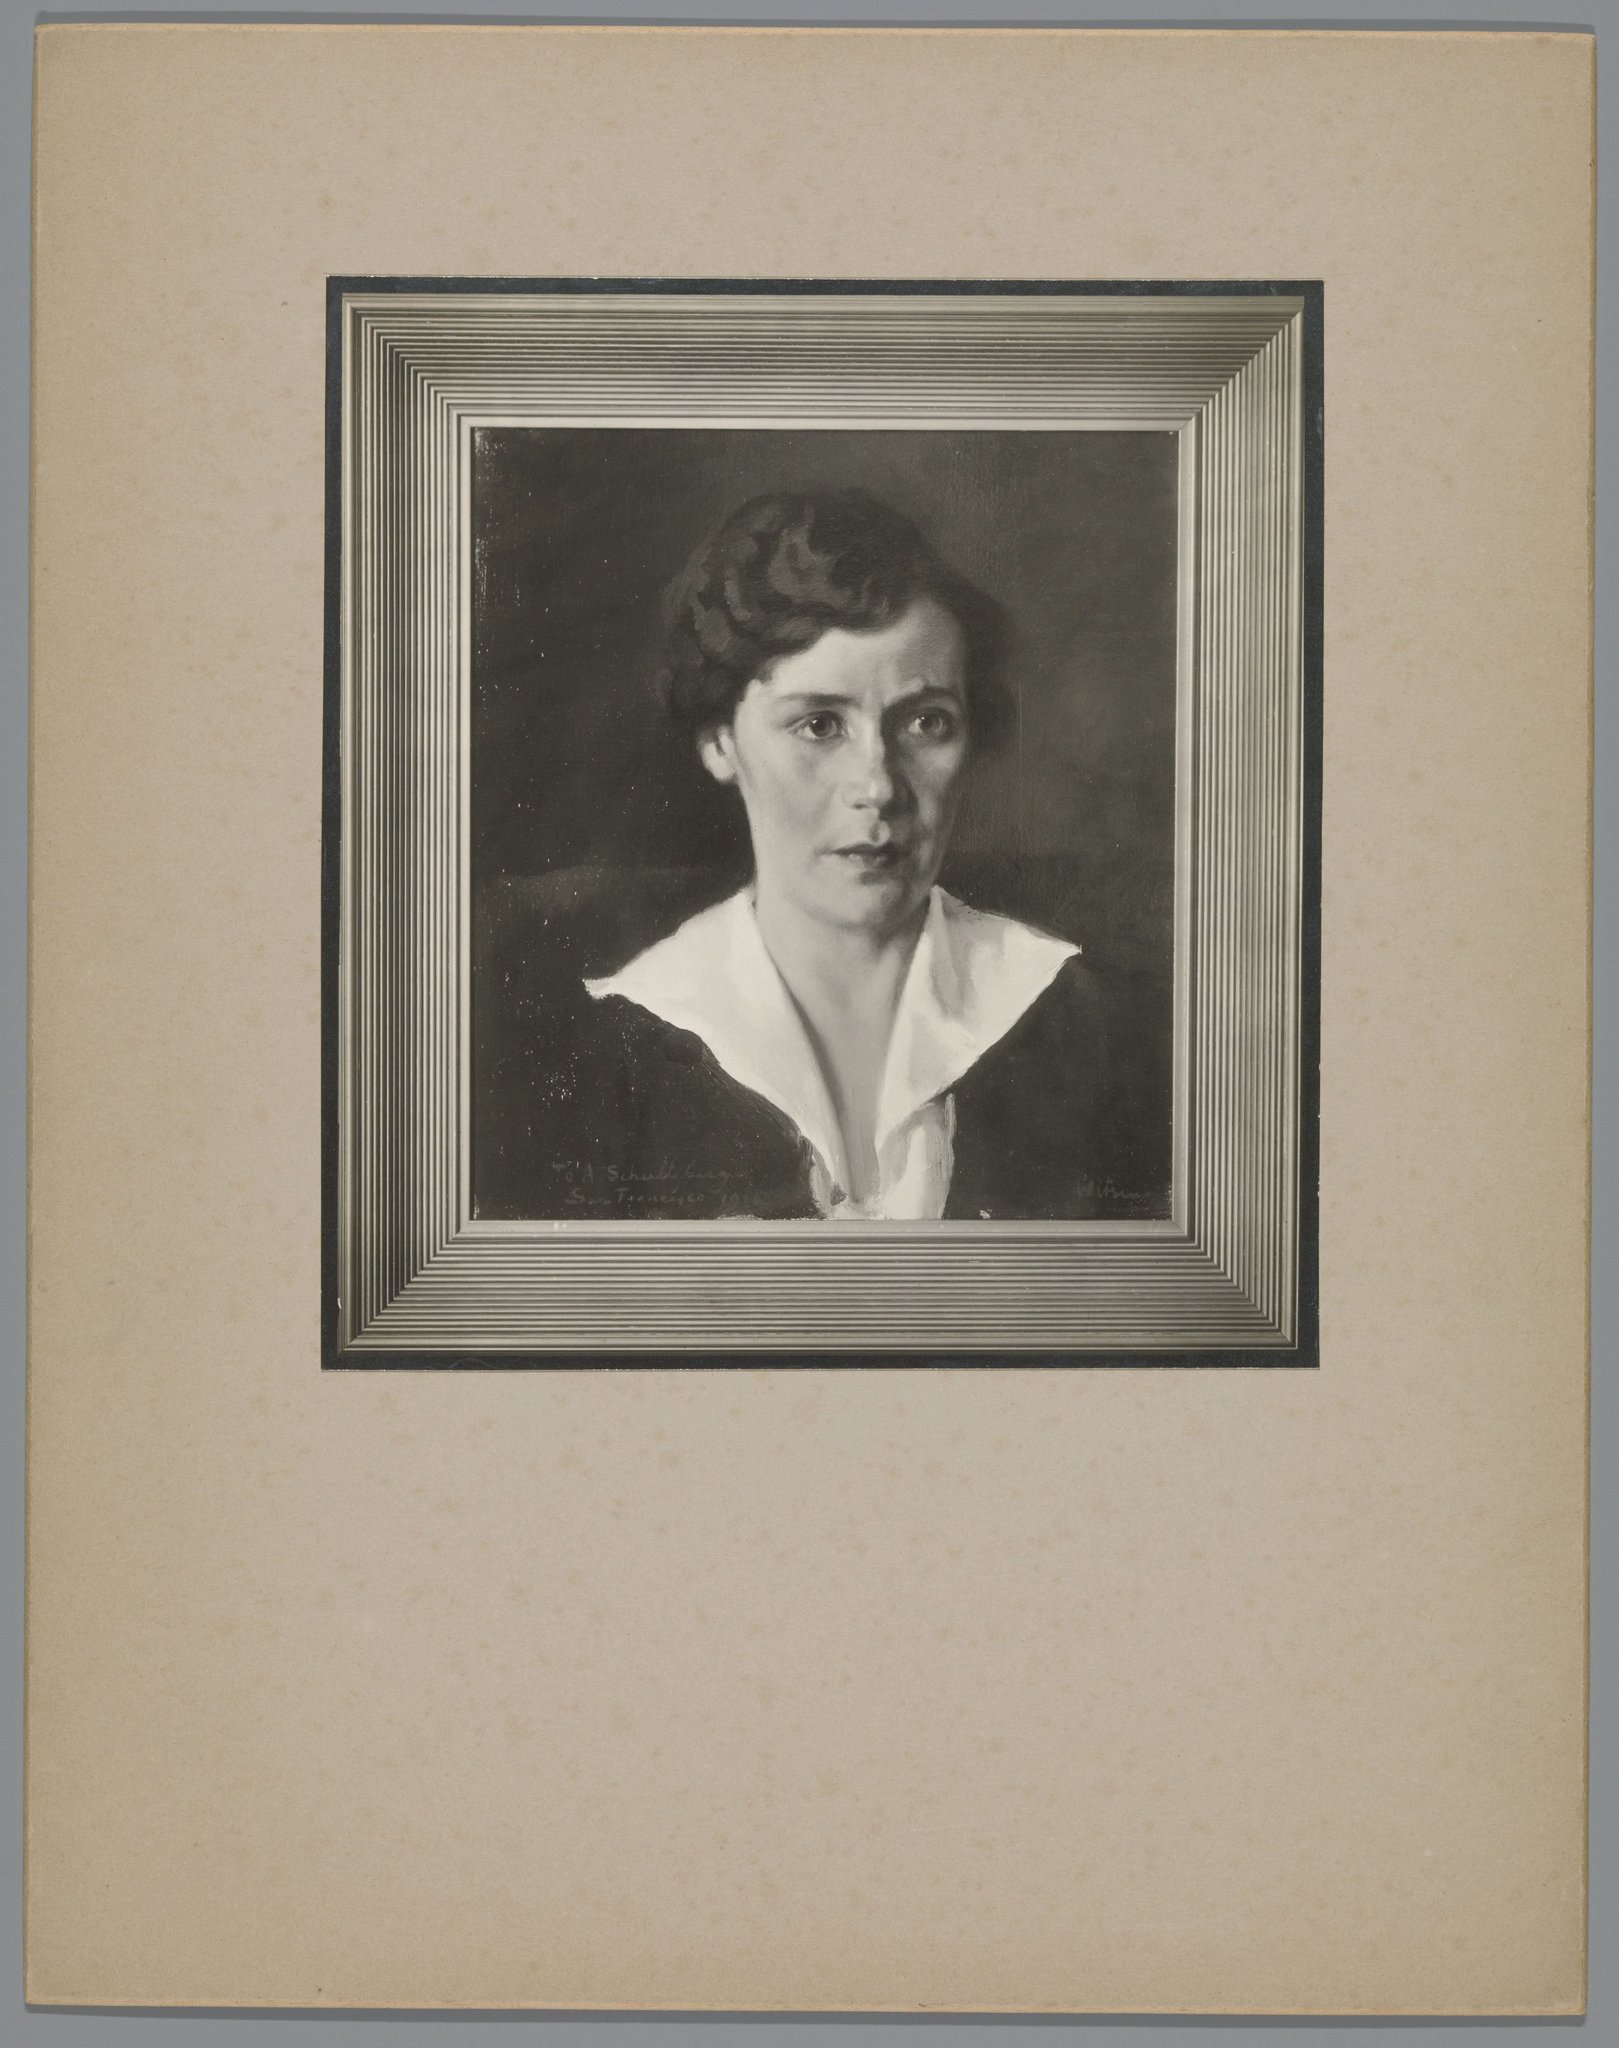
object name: photograph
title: Reproductie naar schilderij van Willem Witsen van een portret van mevrouw A. Schultzberg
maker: Anonymous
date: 1860-1915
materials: cardboard, paper, photographic support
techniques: gelatin silver print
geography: netherlands